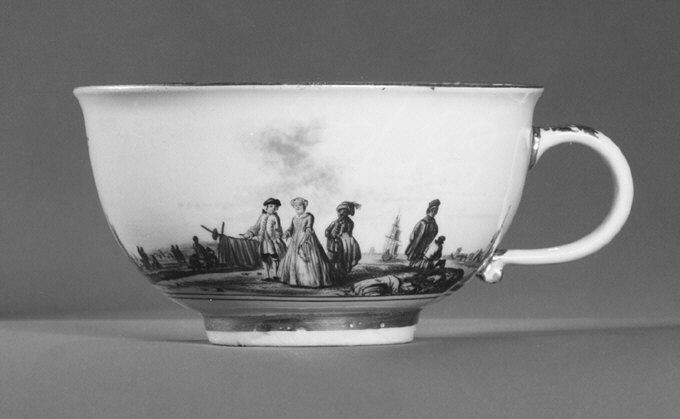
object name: cup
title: Cup (part of a service)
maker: meissen manufactory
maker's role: manufactory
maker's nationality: german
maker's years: 1710-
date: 1701-1800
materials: hard paste porcelain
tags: men,women